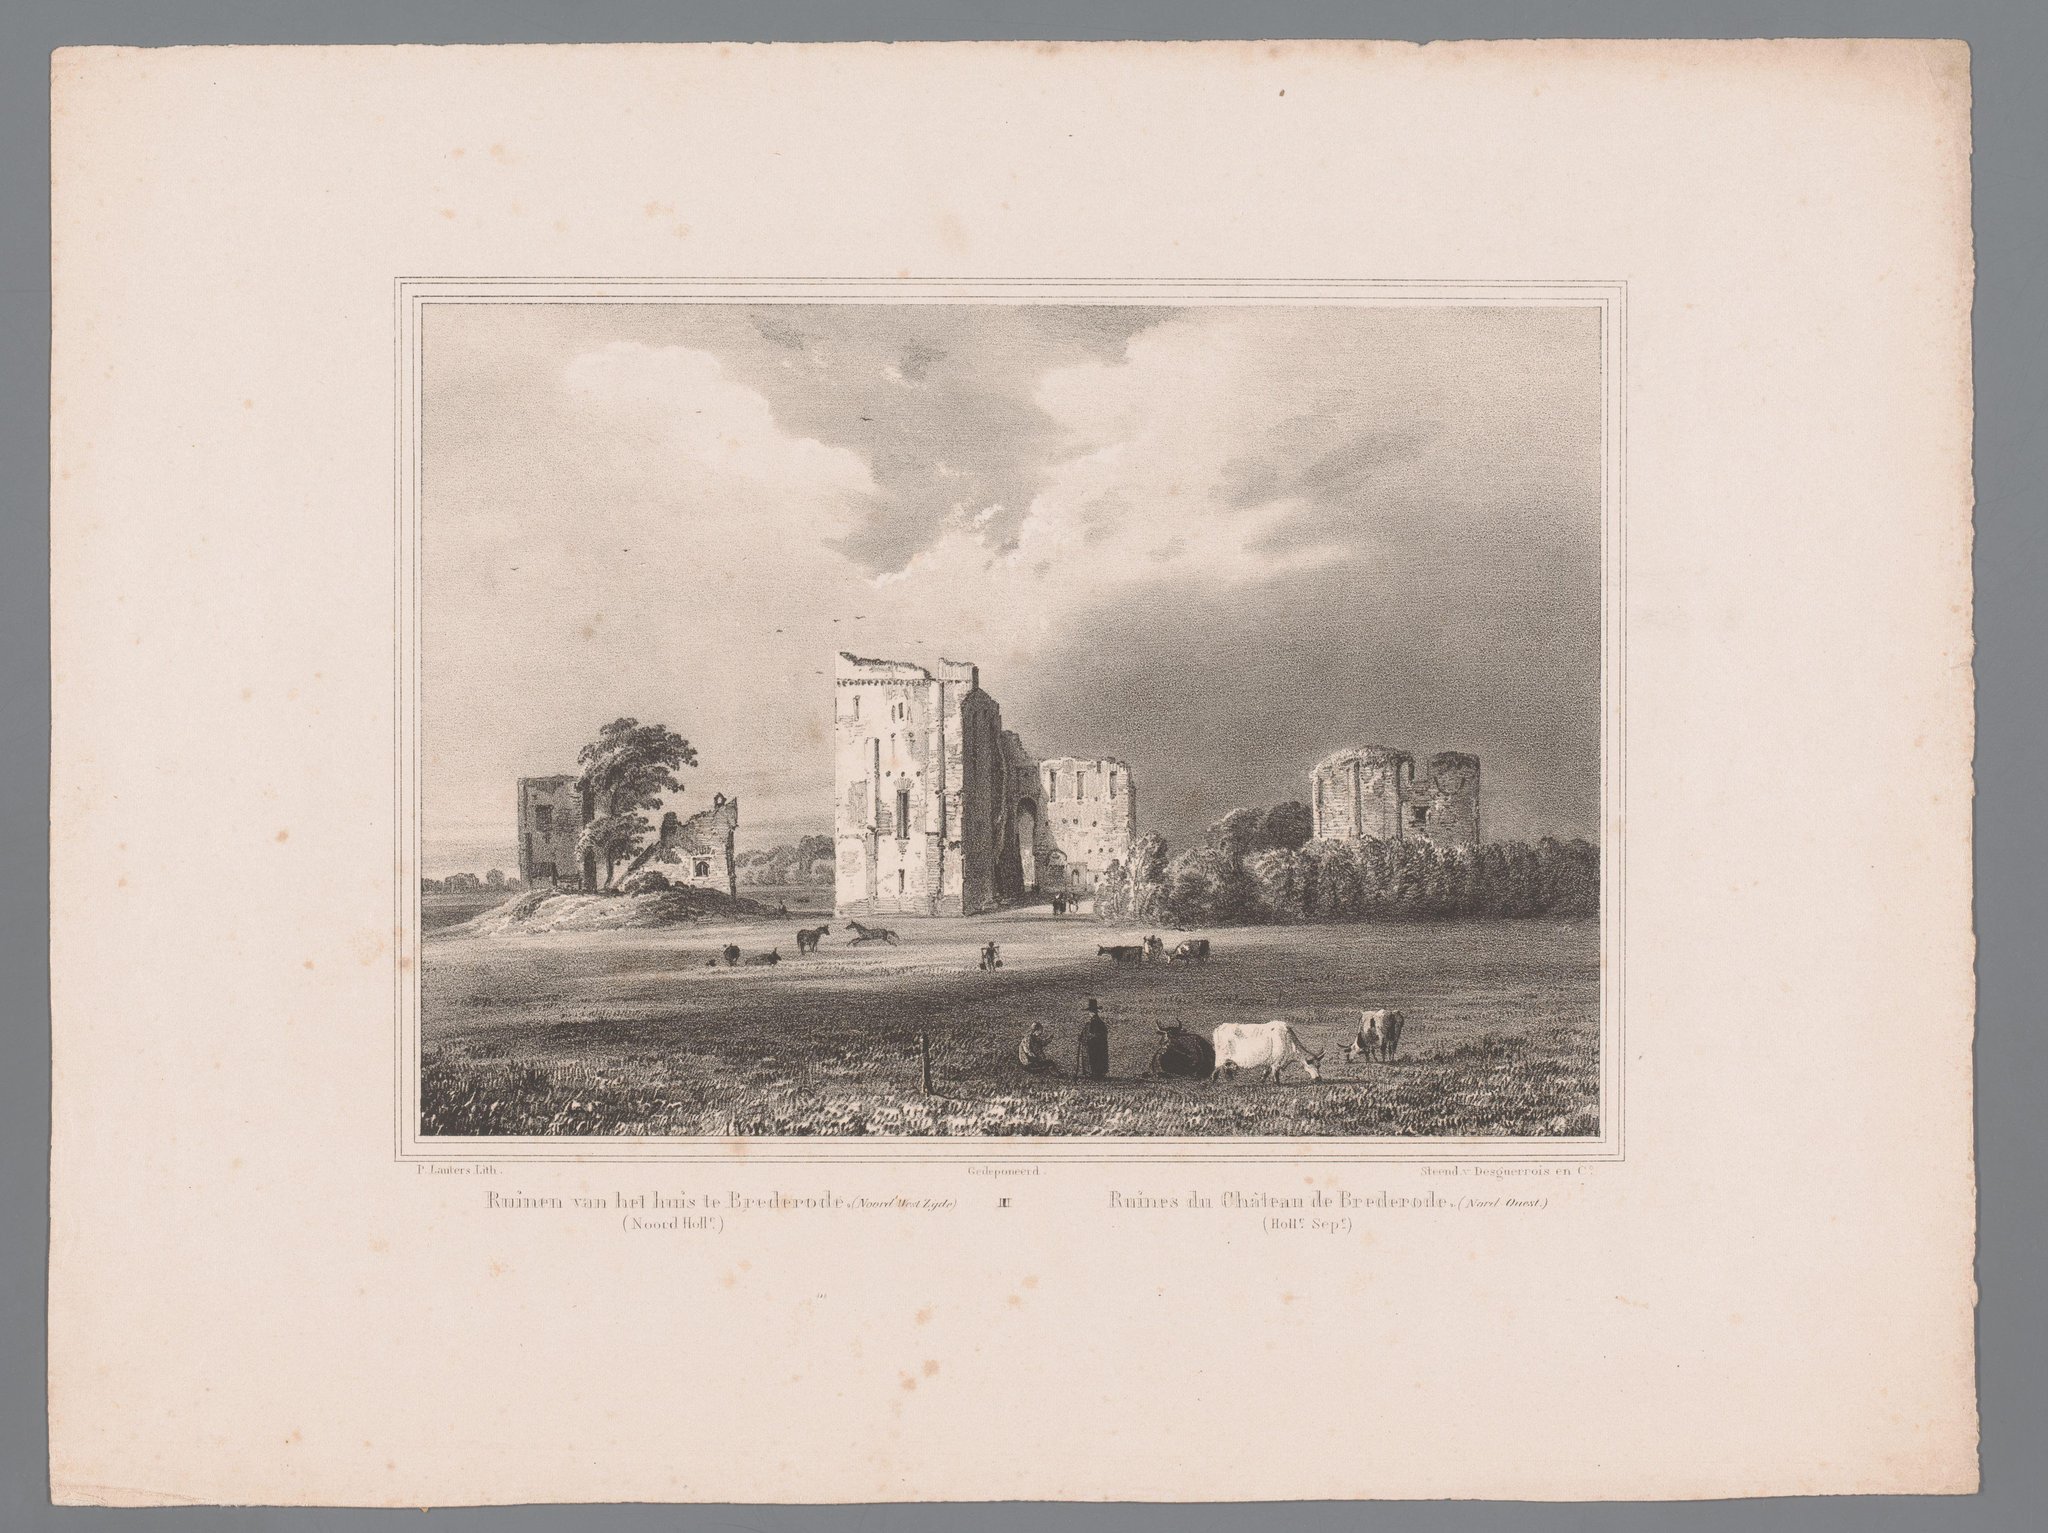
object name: print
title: Nederlandse kastelen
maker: paulus lauters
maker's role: print maker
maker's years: 1806-1875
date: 1827-1875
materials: paper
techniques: lithograph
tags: landscape with ruins, ruin of a dwelling, house, castle, etc.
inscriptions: : ‘Gedeponeerd’, collector's mark: Lugt 2228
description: Prent maakt deel uit van een serie met Nederlandse kastelen. Over deze serie is verder niets bekend. Het Rijksmuseum Amsterdam bezit zes prenten uit deze serie.